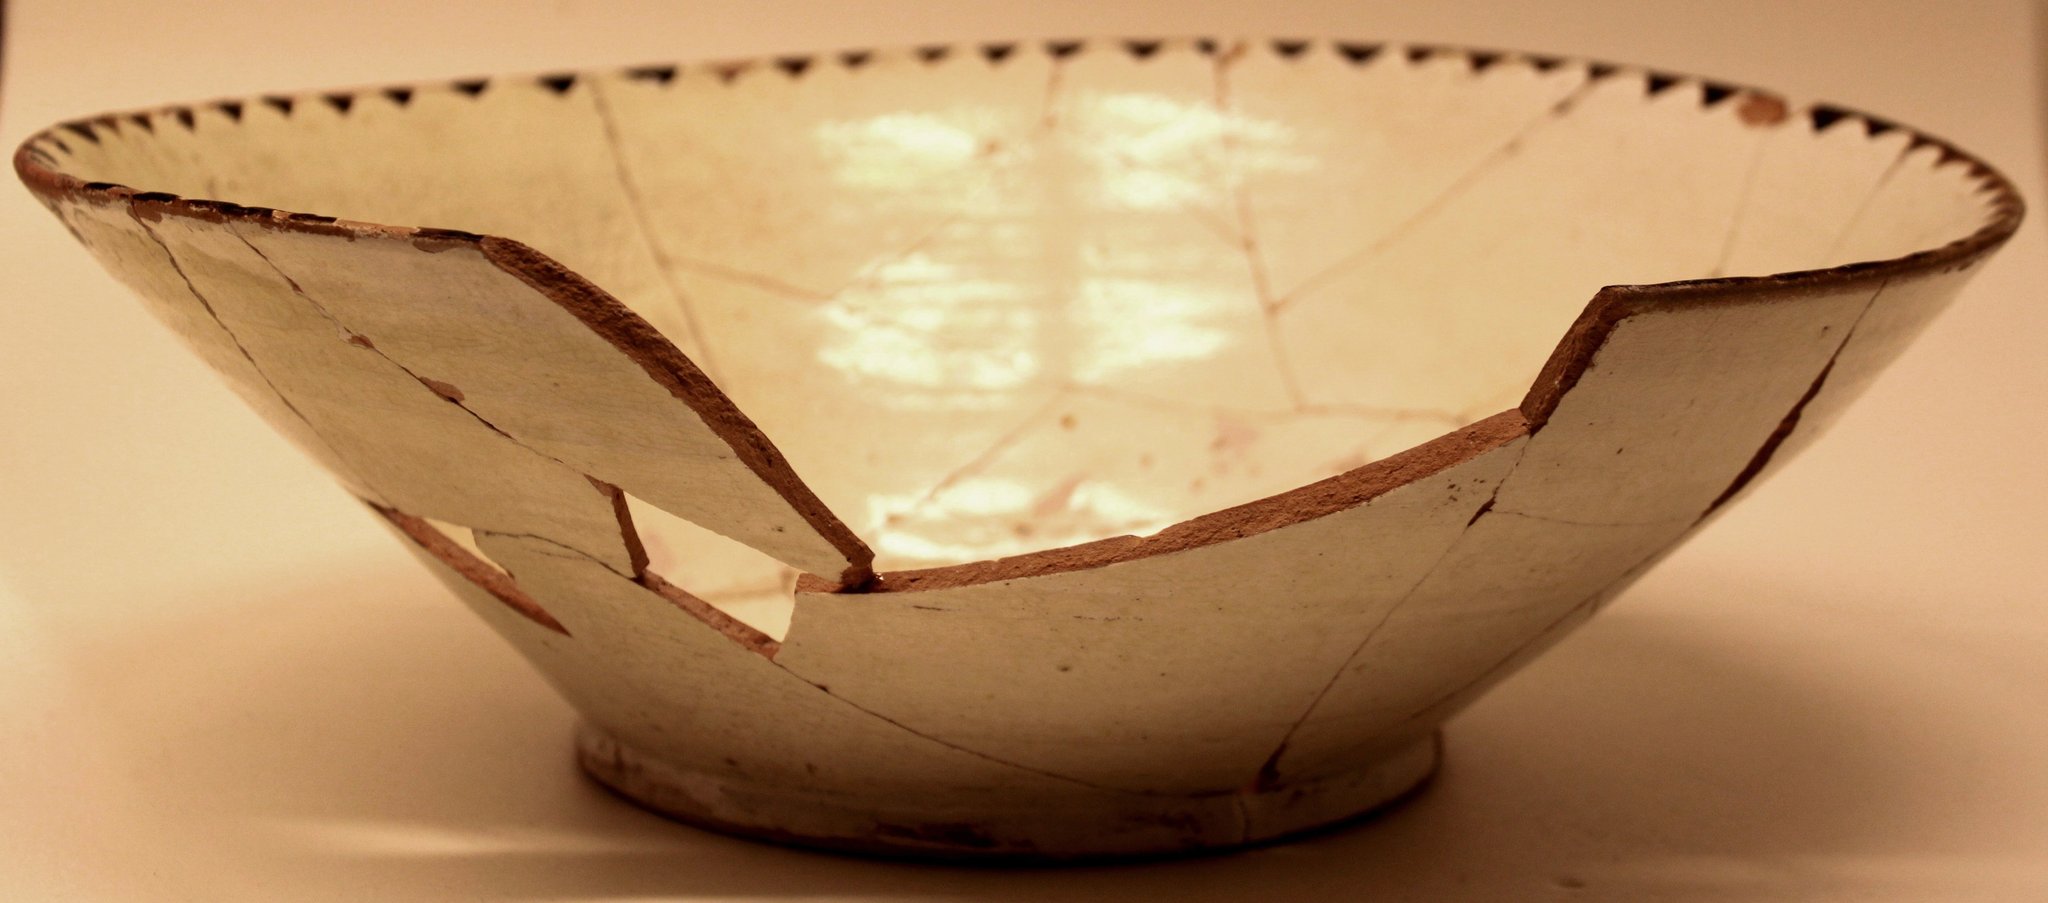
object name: bowl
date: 801-1000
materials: earthenware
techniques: glazing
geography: iran